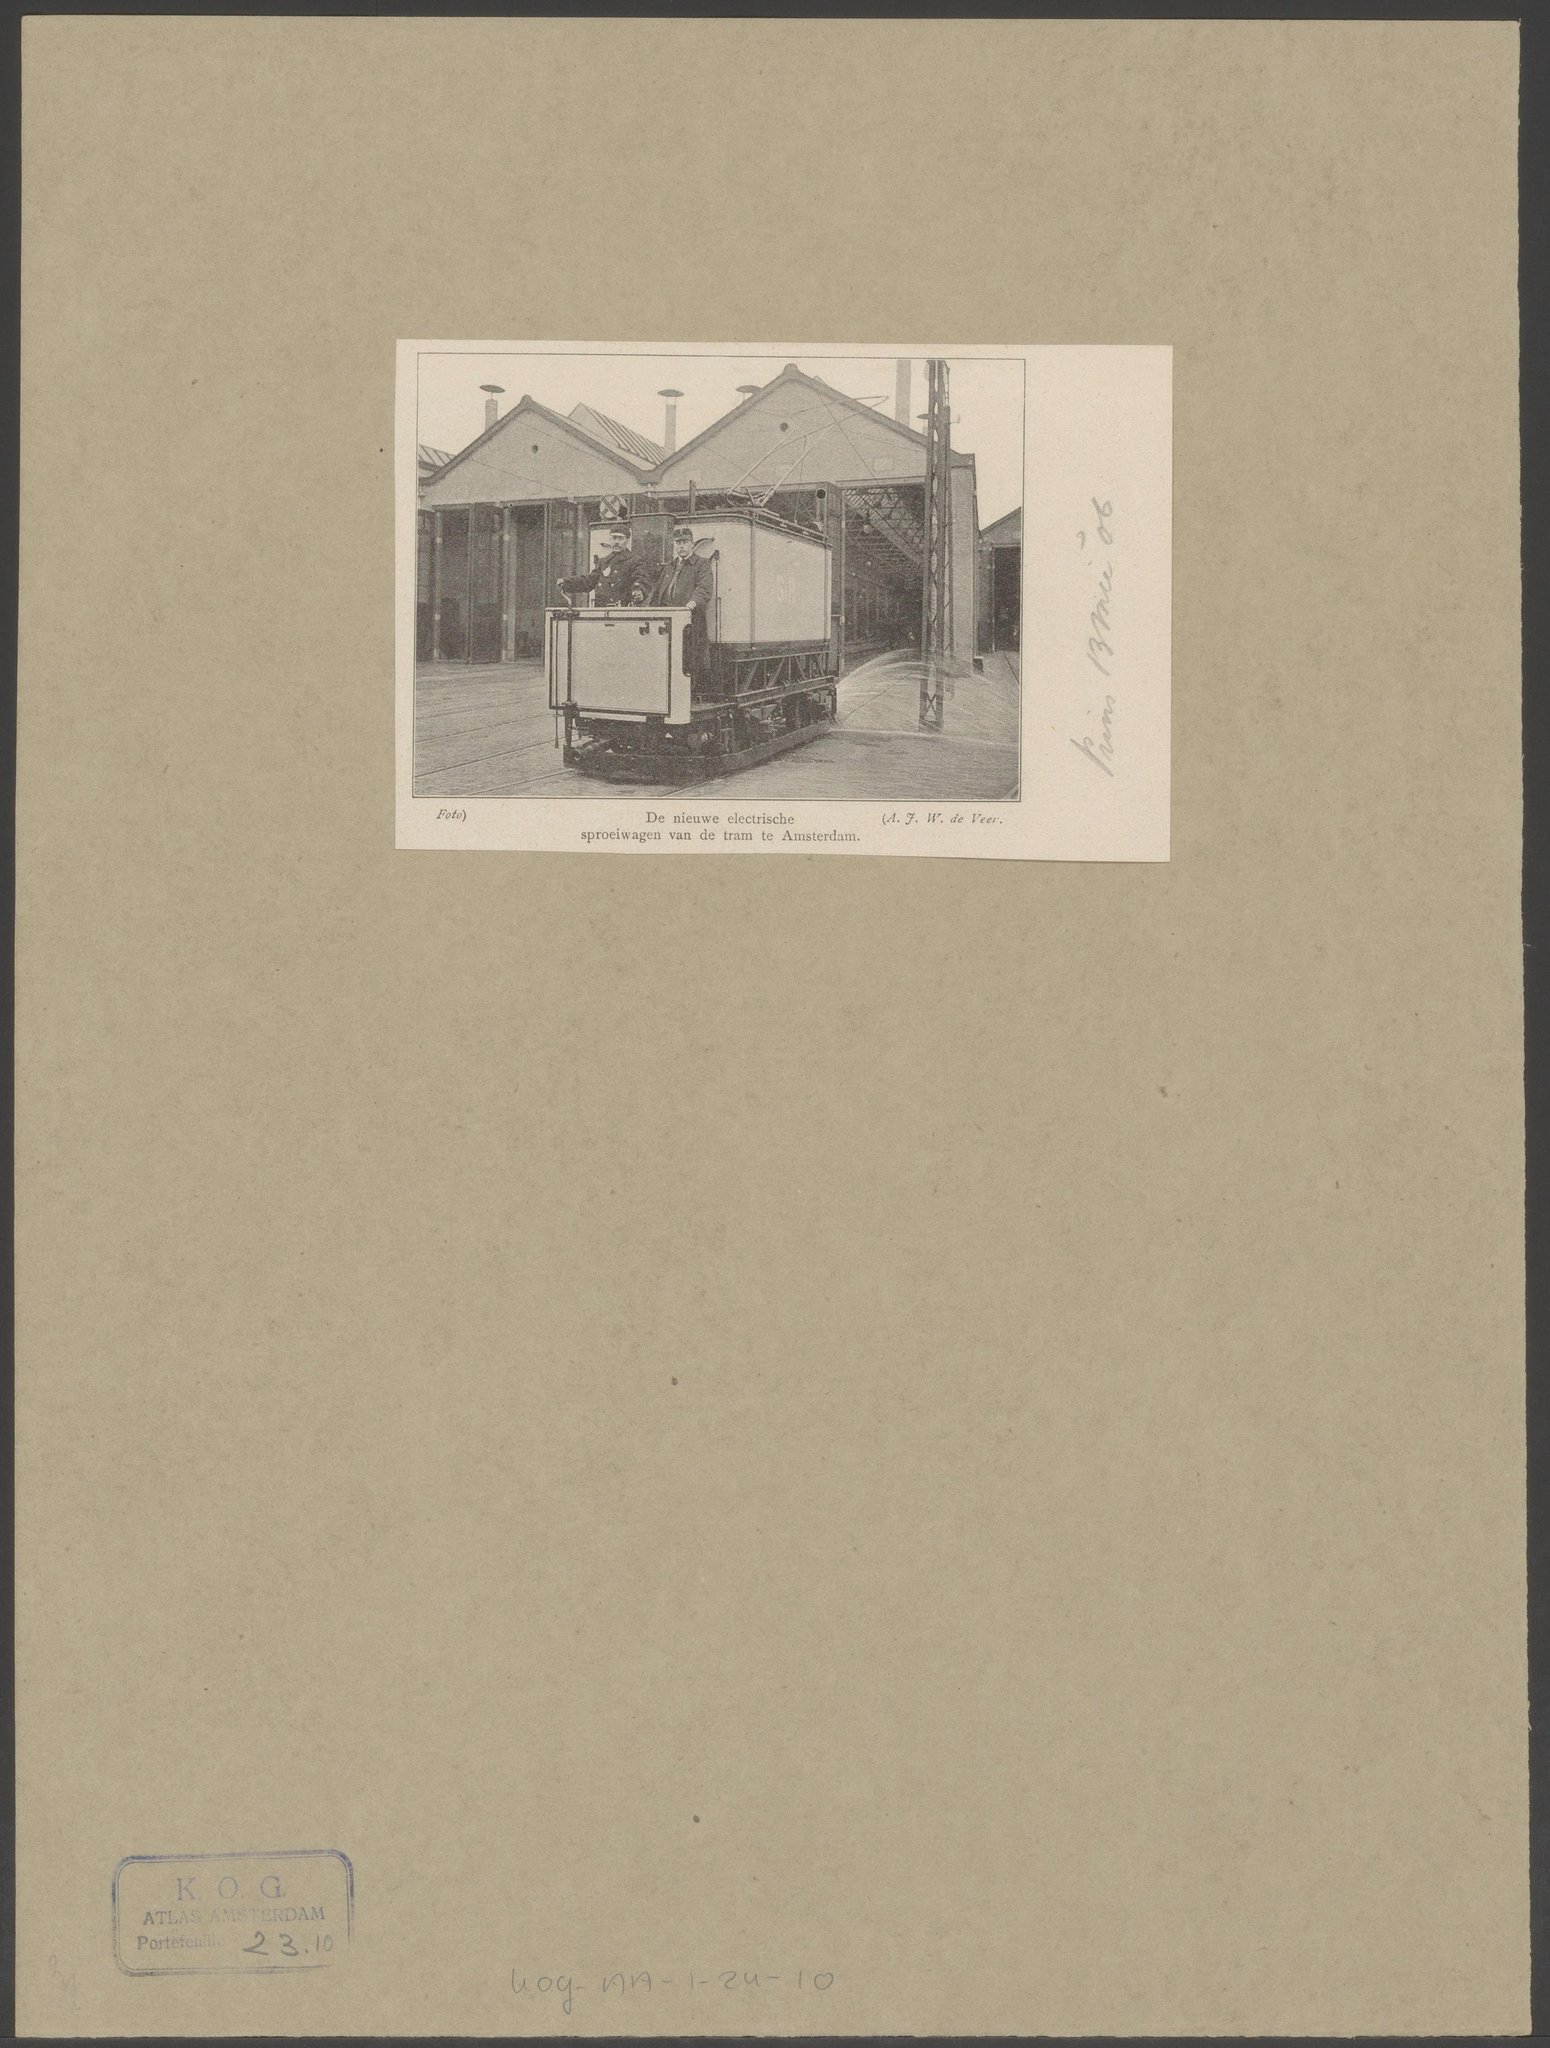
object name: photomechanical print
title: De nieuwe electrische sproeiwagen van de tram te Amsterdam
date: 1906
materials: paper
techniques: letterpress printing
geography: amsterdam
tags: tram, amsterdam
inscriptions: collector's mark: Lugt 1641b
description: Onderwerpsrubriek binnen de Atlas Amsterdam: Gemeentebedrijven.